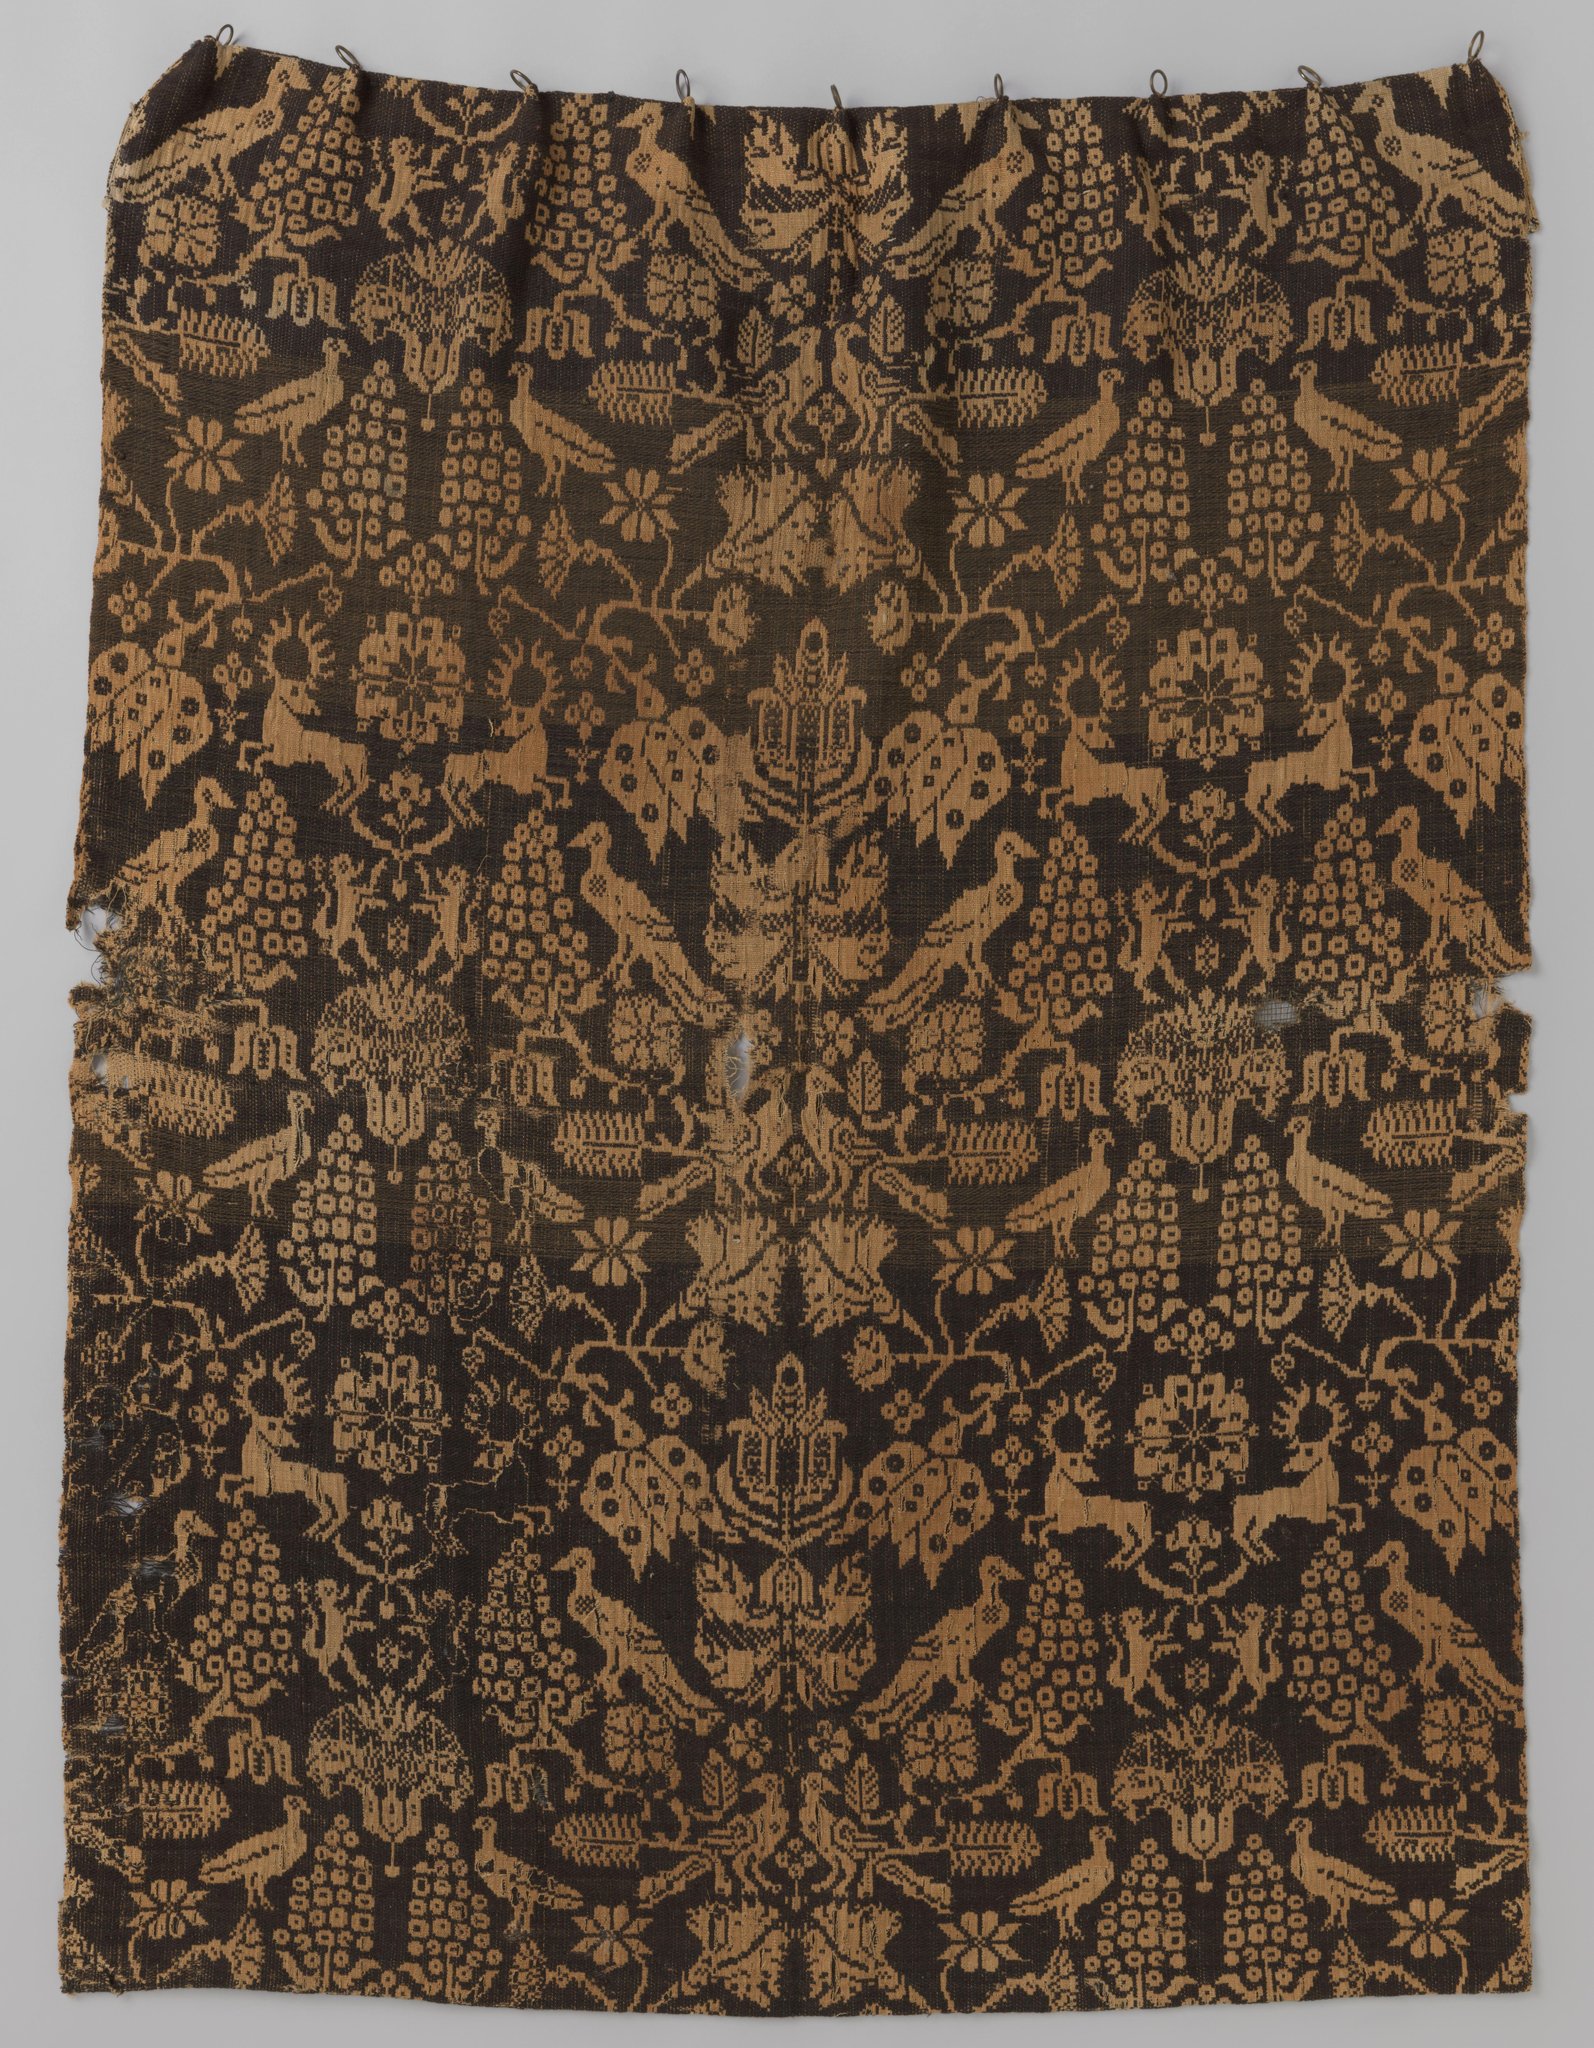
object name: bed curtain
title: Bedgordijn van "Beiderwand" weefsel in zwart en wit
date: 1650-1700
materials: linen, wool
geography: east frisia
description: Bedgordijn van z.g. "Beiderwand" weefsel. Het patroon in zwart en wit, is oneindig en symmetrisch op verticale assen, opgebouwd. De tekening bestaat uit vogeltjes, hertjes, palmetten, anjers, tulpen en druiventrossen. De texture is een dubbelweefsel, zodat aan de ene zijde het patroon wit op zwart is aan de andere zijde zwart op wit. Het gordijn is van wol en linnen.